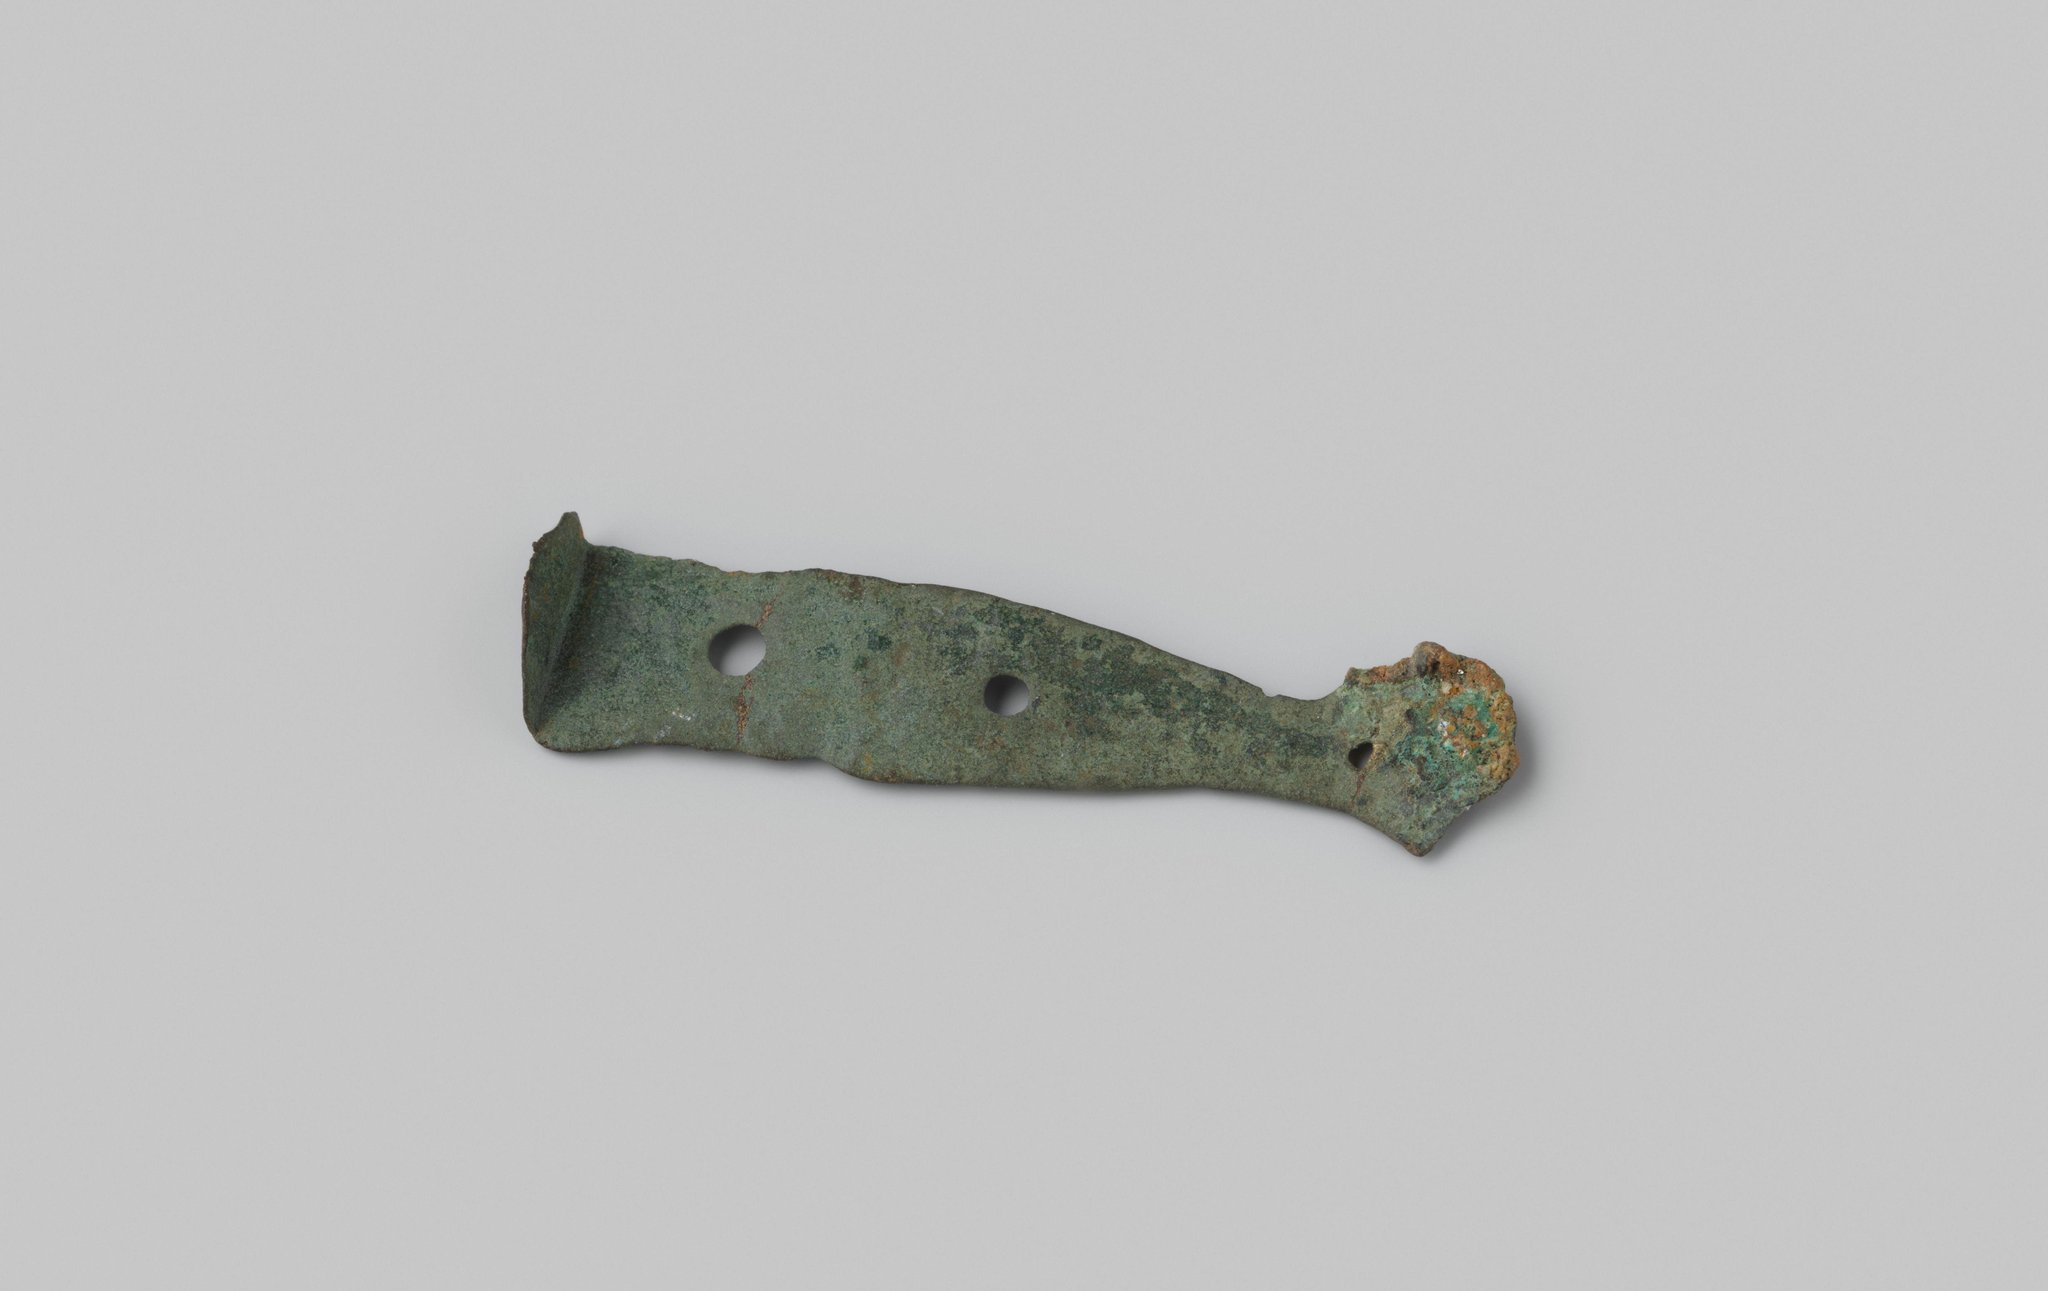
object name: part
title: Onderdeel of hulpstuk afkomstig uit het wrak van de Oost-Indiëvaarder Hollandia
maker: Anonymous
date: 1700-1743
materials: copper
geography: netherlands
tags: verenigde oostindische compagnie, hollandia (schip)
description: Strip-shaped fitting; fragm, eroded: flat, tapering towards spatula-shaped end, other end flanged. 3 holes along centre.